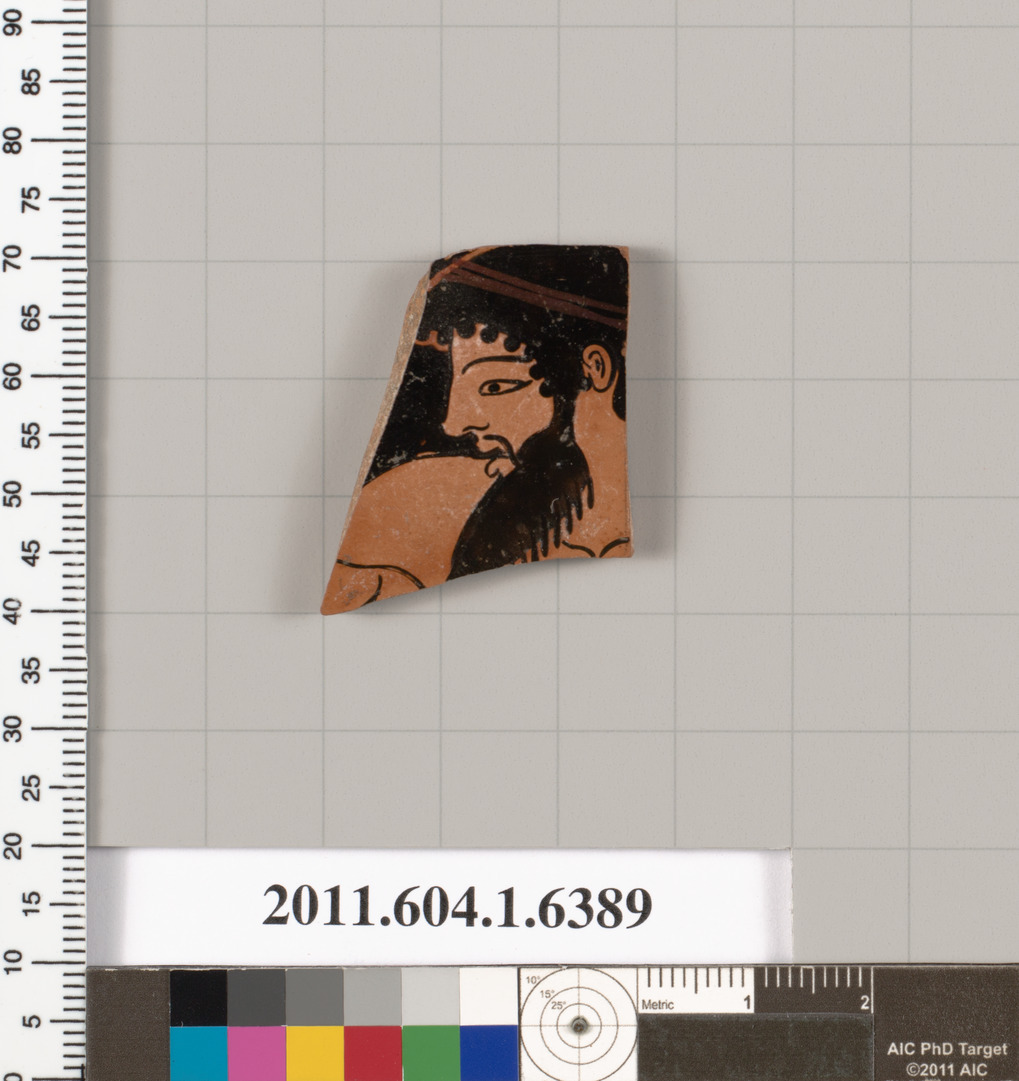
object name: kylix fragment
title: Terracotta fragment of a kylix (drinking cup)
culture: greek, attic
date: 490-480 BCE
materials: terracotta